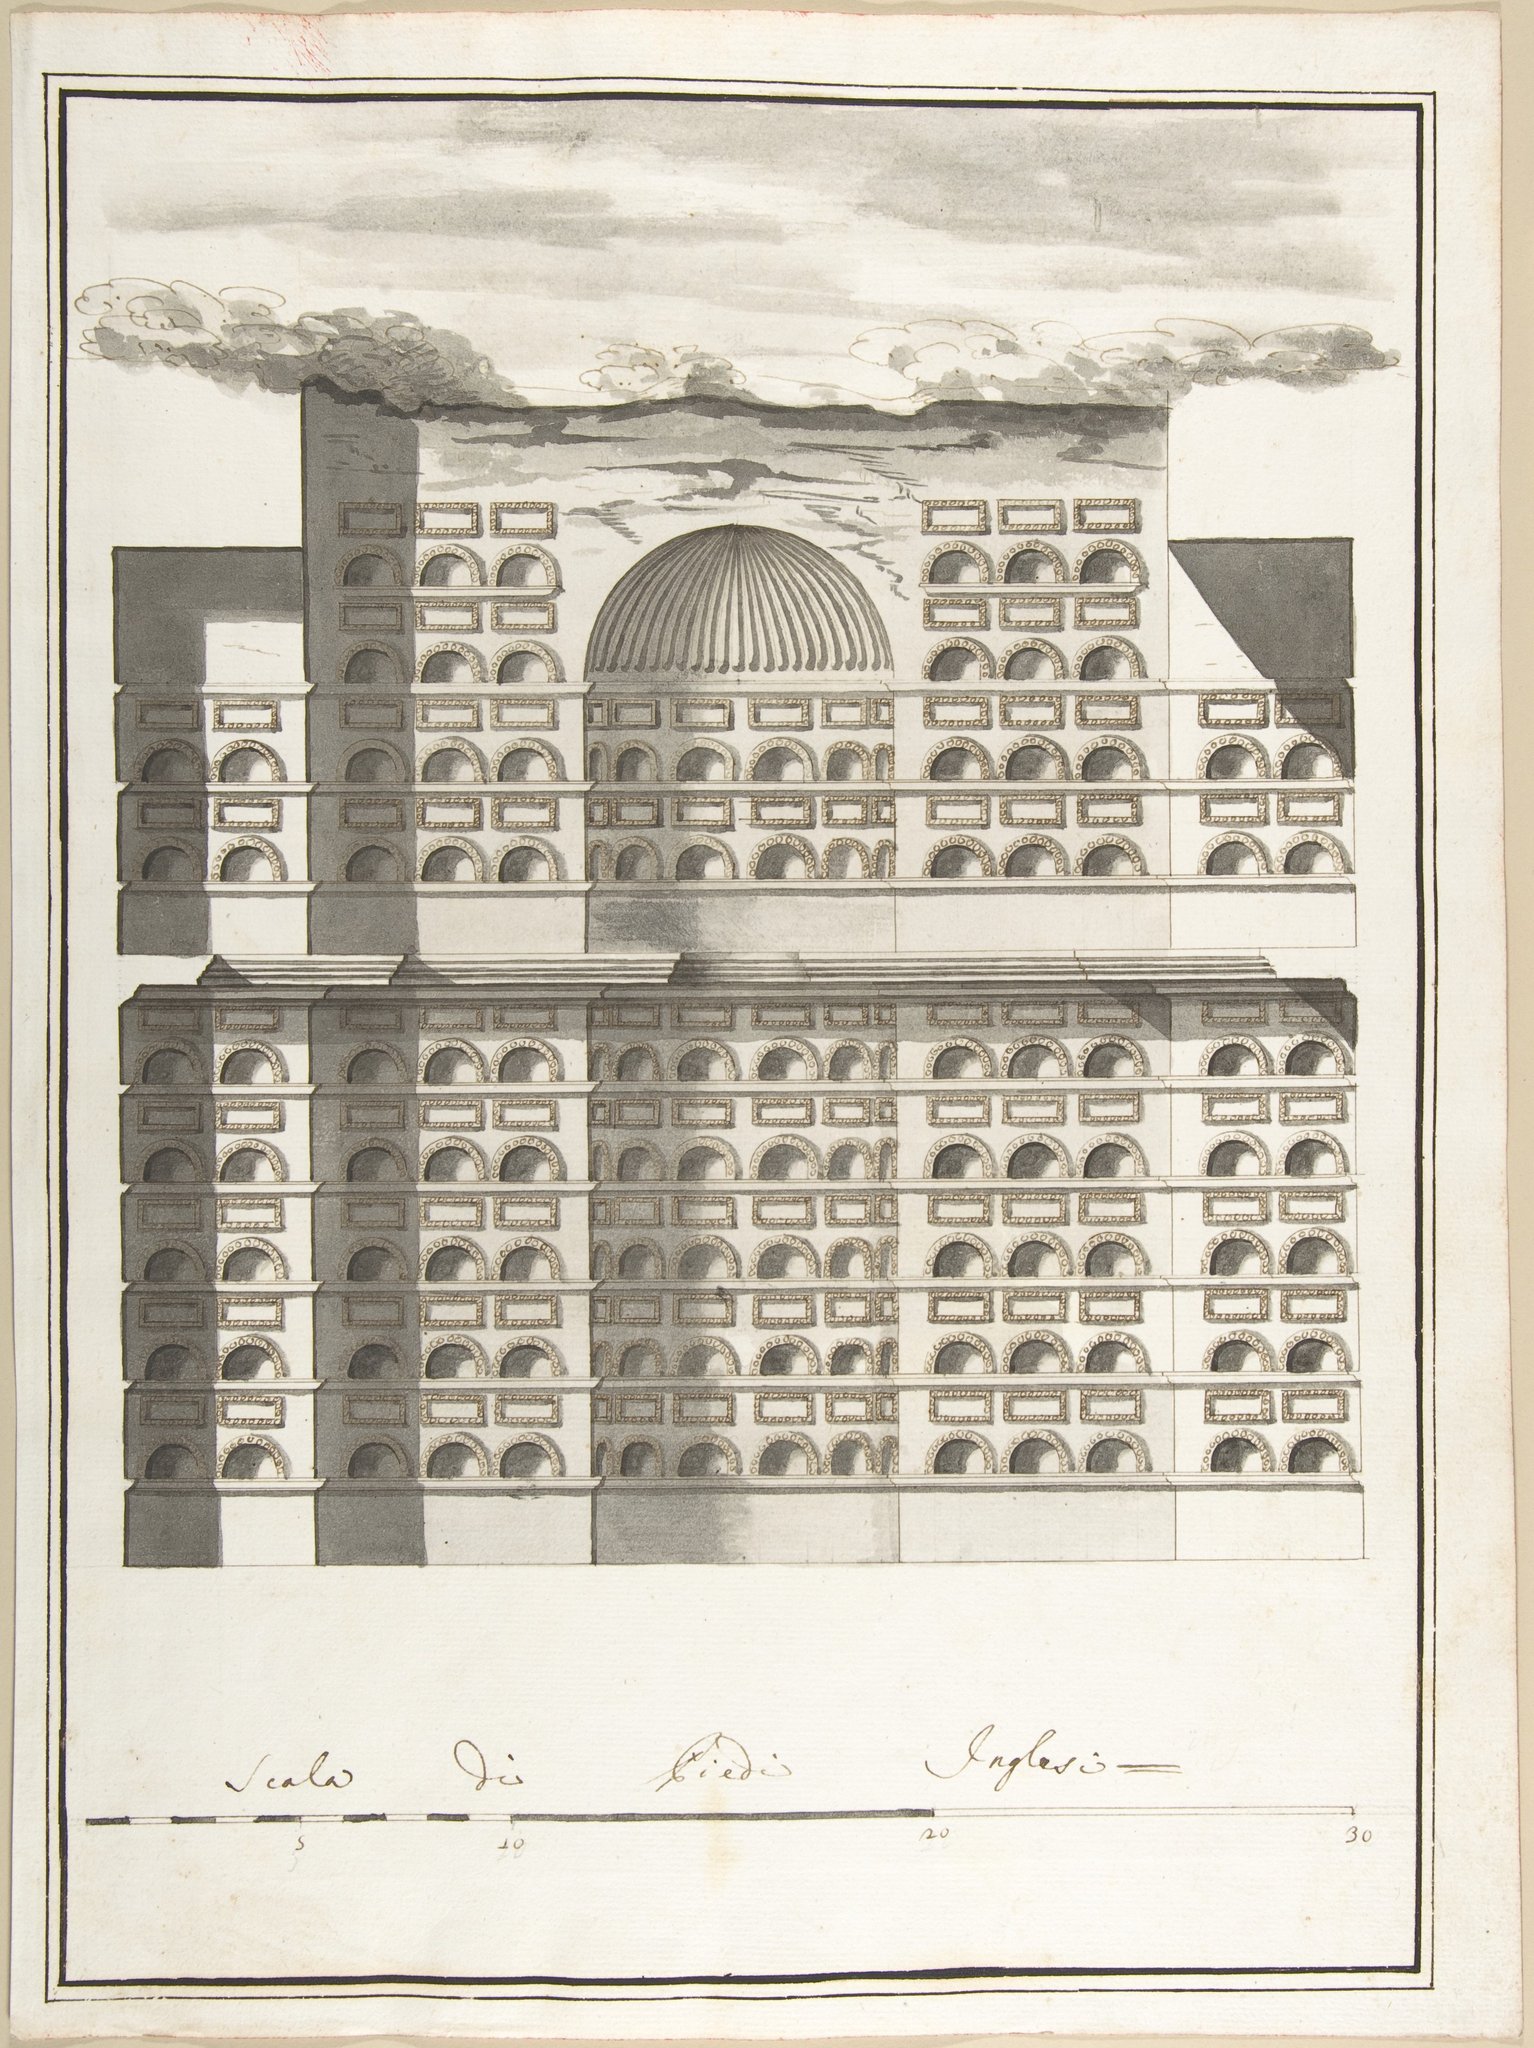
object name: drawing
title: Elevation of the Interior of a Columbarium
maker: pietro paolo coccetti (cocchetti)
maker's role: artist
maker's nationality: italian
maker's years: 1710-1727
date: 1710-1727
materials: graphite, ink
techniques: brush, pen, wash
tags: architecture,buildings